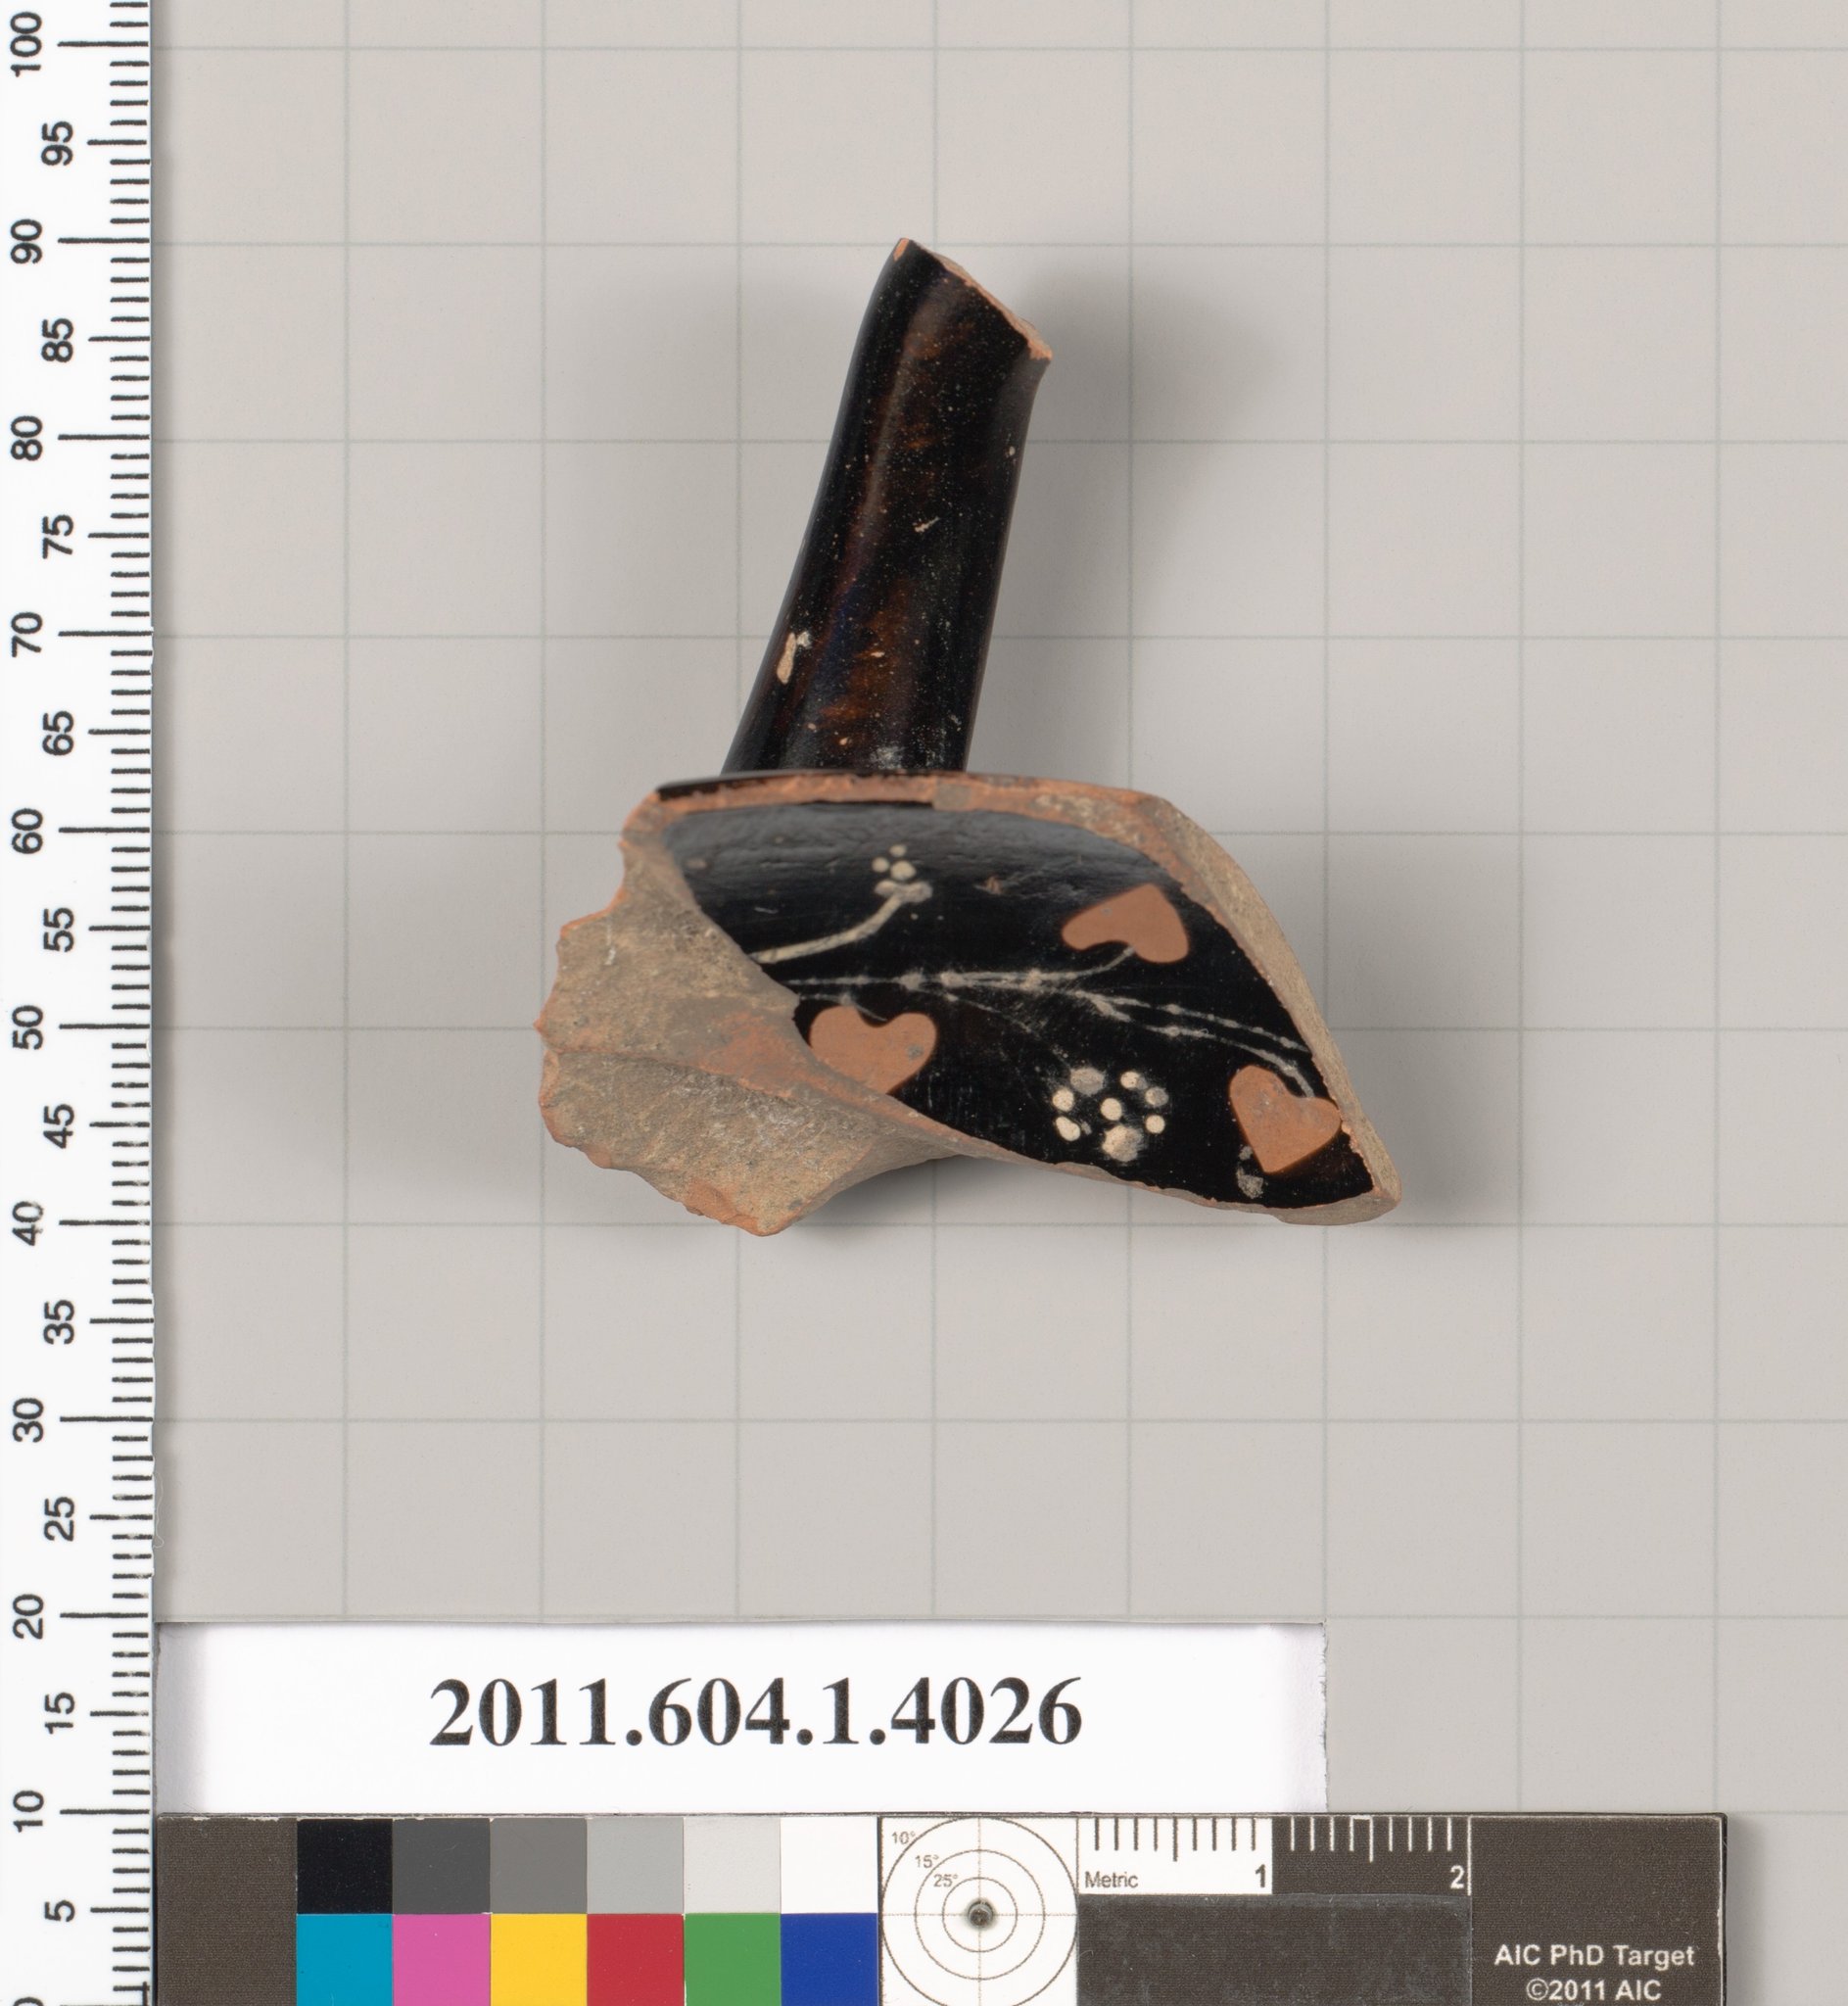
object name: kylix fragment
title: Terracotta rim fragment of a kylix (drinking cup)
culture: greek, attic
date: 460-440 BCE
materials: terracotta